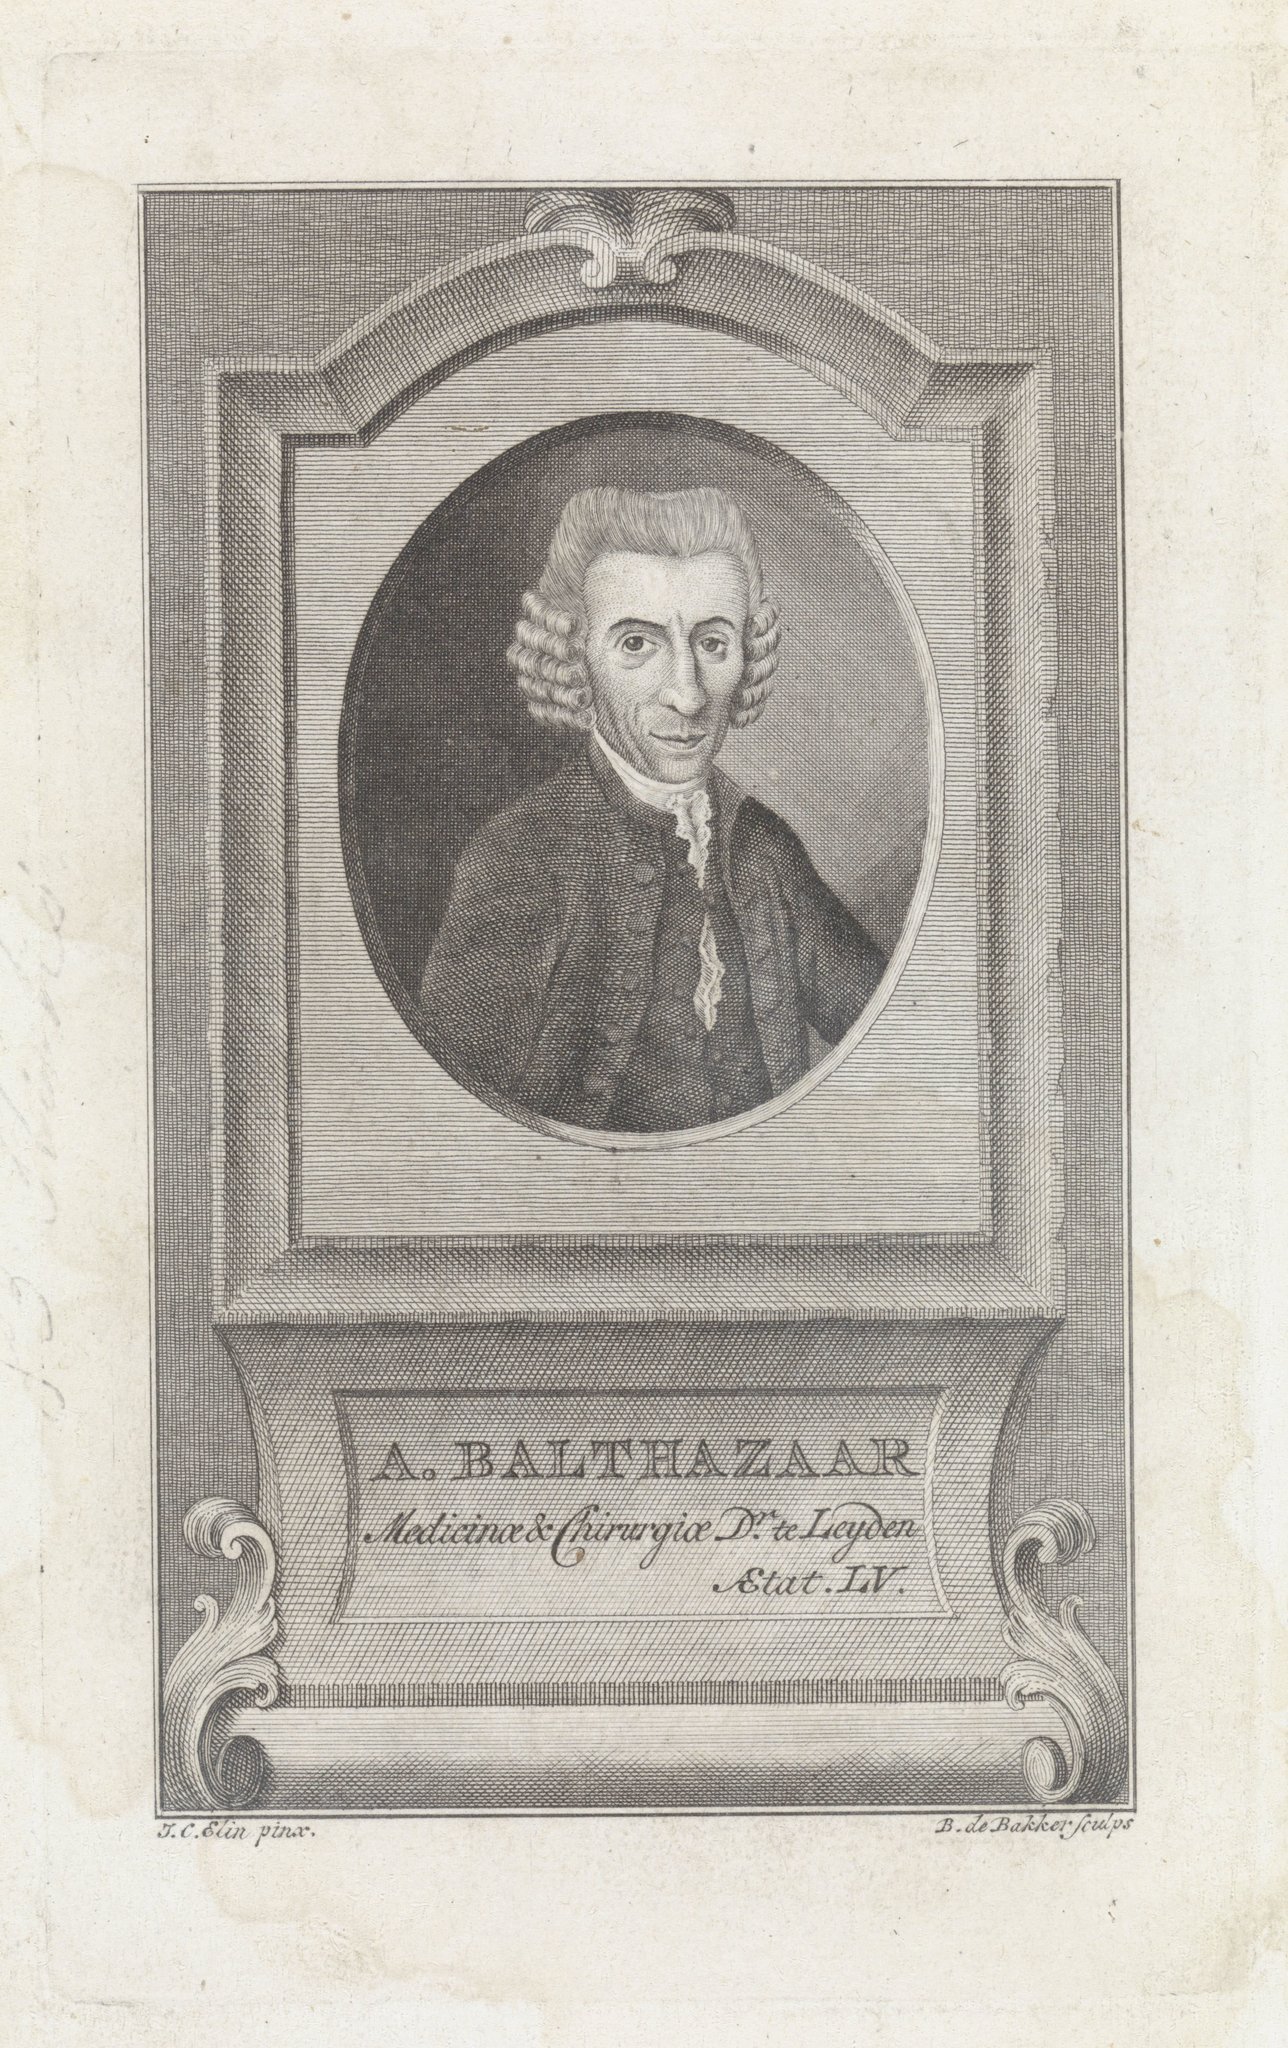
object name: print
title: Portret van medicus Alexander Balthazaar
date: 1762-1804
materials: paper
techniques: engraving, etching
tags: physician, doctor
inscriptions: collector's mark: Lugt 2166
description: Prent naar schilderij van Christiaan Johann Elin.